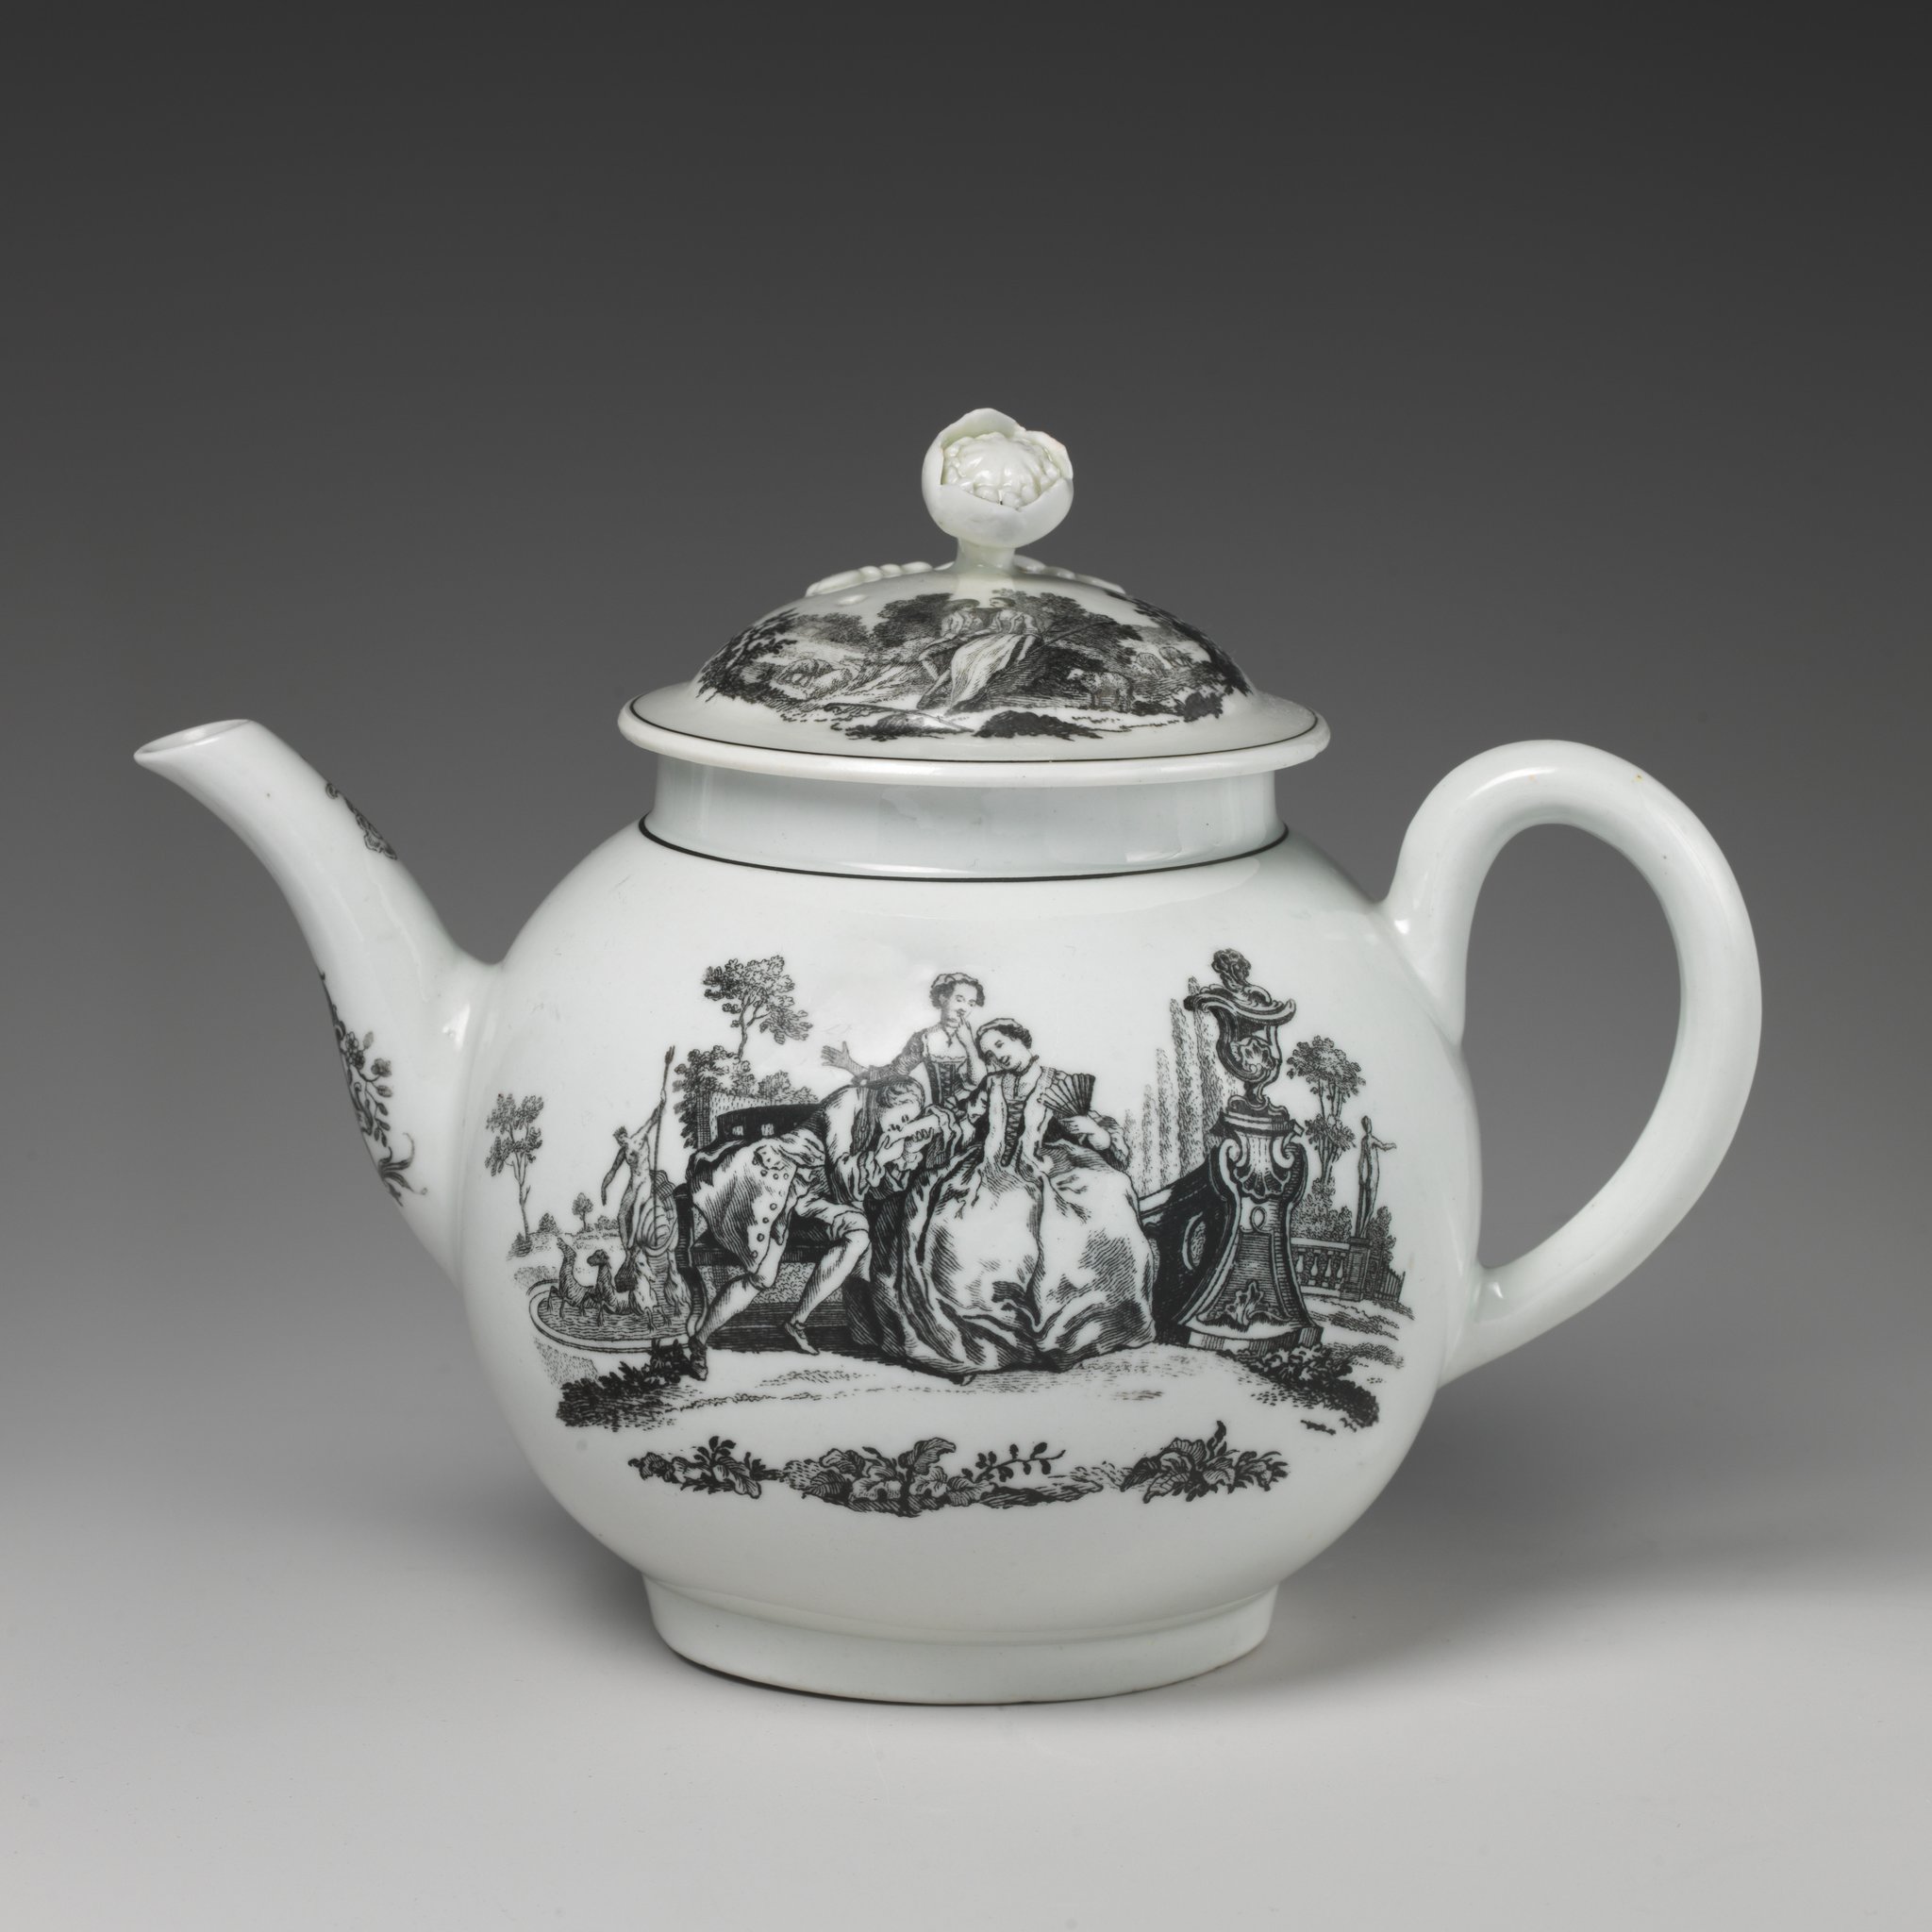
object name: teapot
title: Teapot with L’amour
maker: worcester factory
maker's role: factory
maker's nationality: british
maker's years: 1751-2008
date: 1765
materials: soft paste porcelain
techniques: transfer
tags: couples,men,women